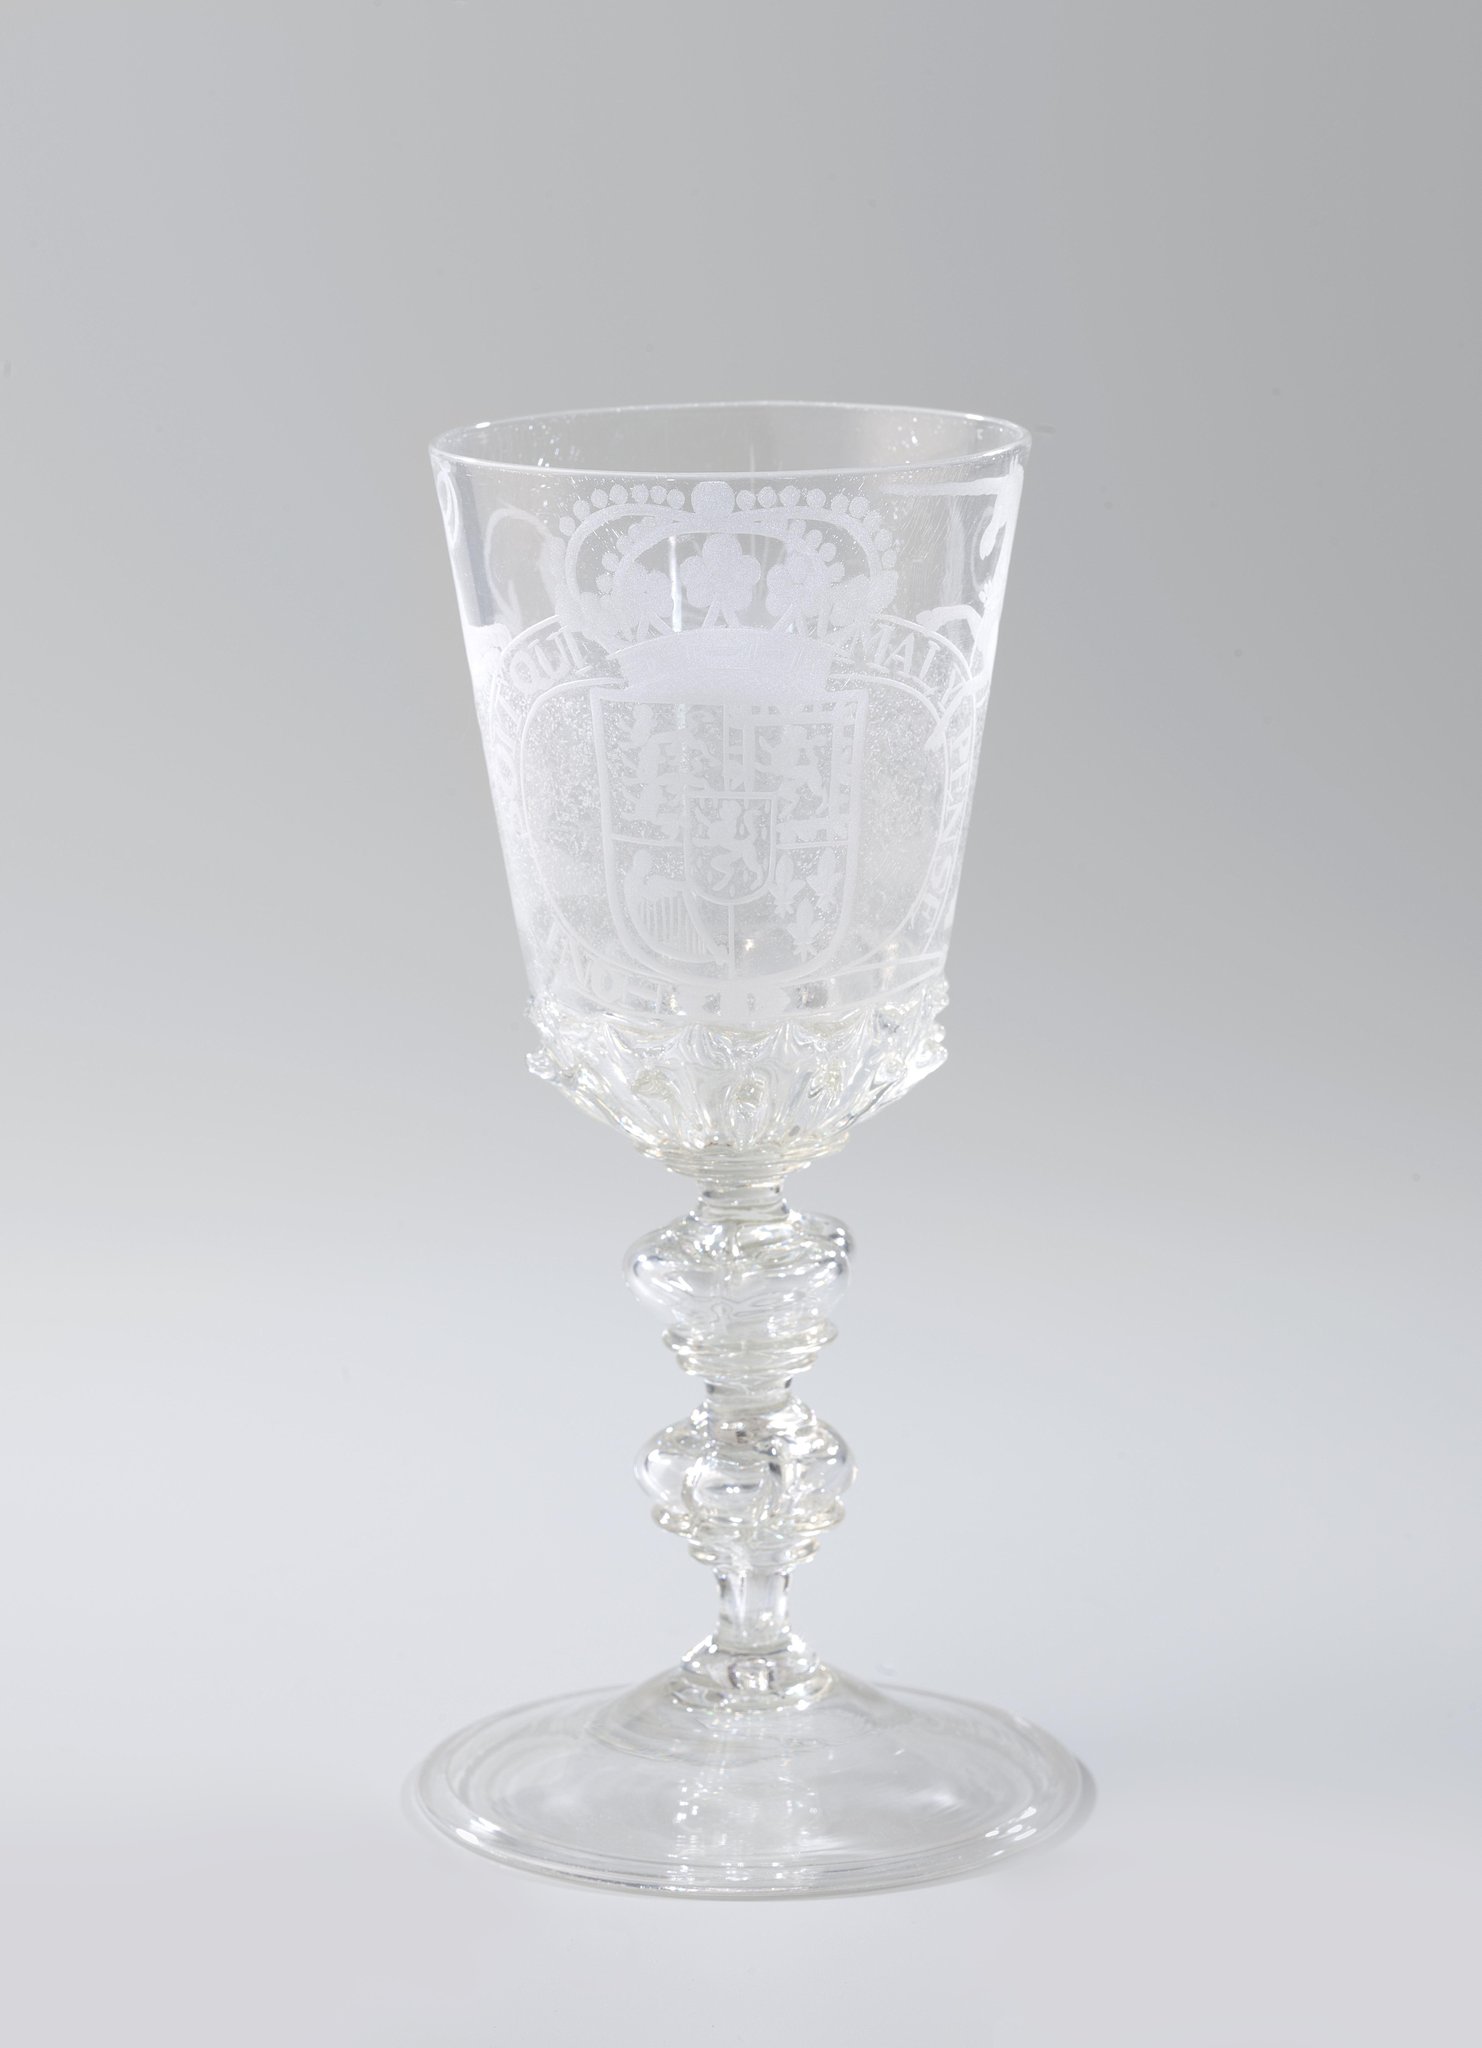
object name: lid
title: Bokaal met deksel, met het wapen van Groot-Brittannië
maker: Anonymous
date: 1680-1700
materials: glass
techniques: façon de venise, glassblowing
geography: low countries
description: Bokaal met deksel, holle balusterstam met twee vier en vijflobbige knopen. Op de kelk geslepen het wapen van Groot-Brittannië en als hartschild de Nassauer leeuw; dan een stralende zon. Op het deksel bloemtakken.